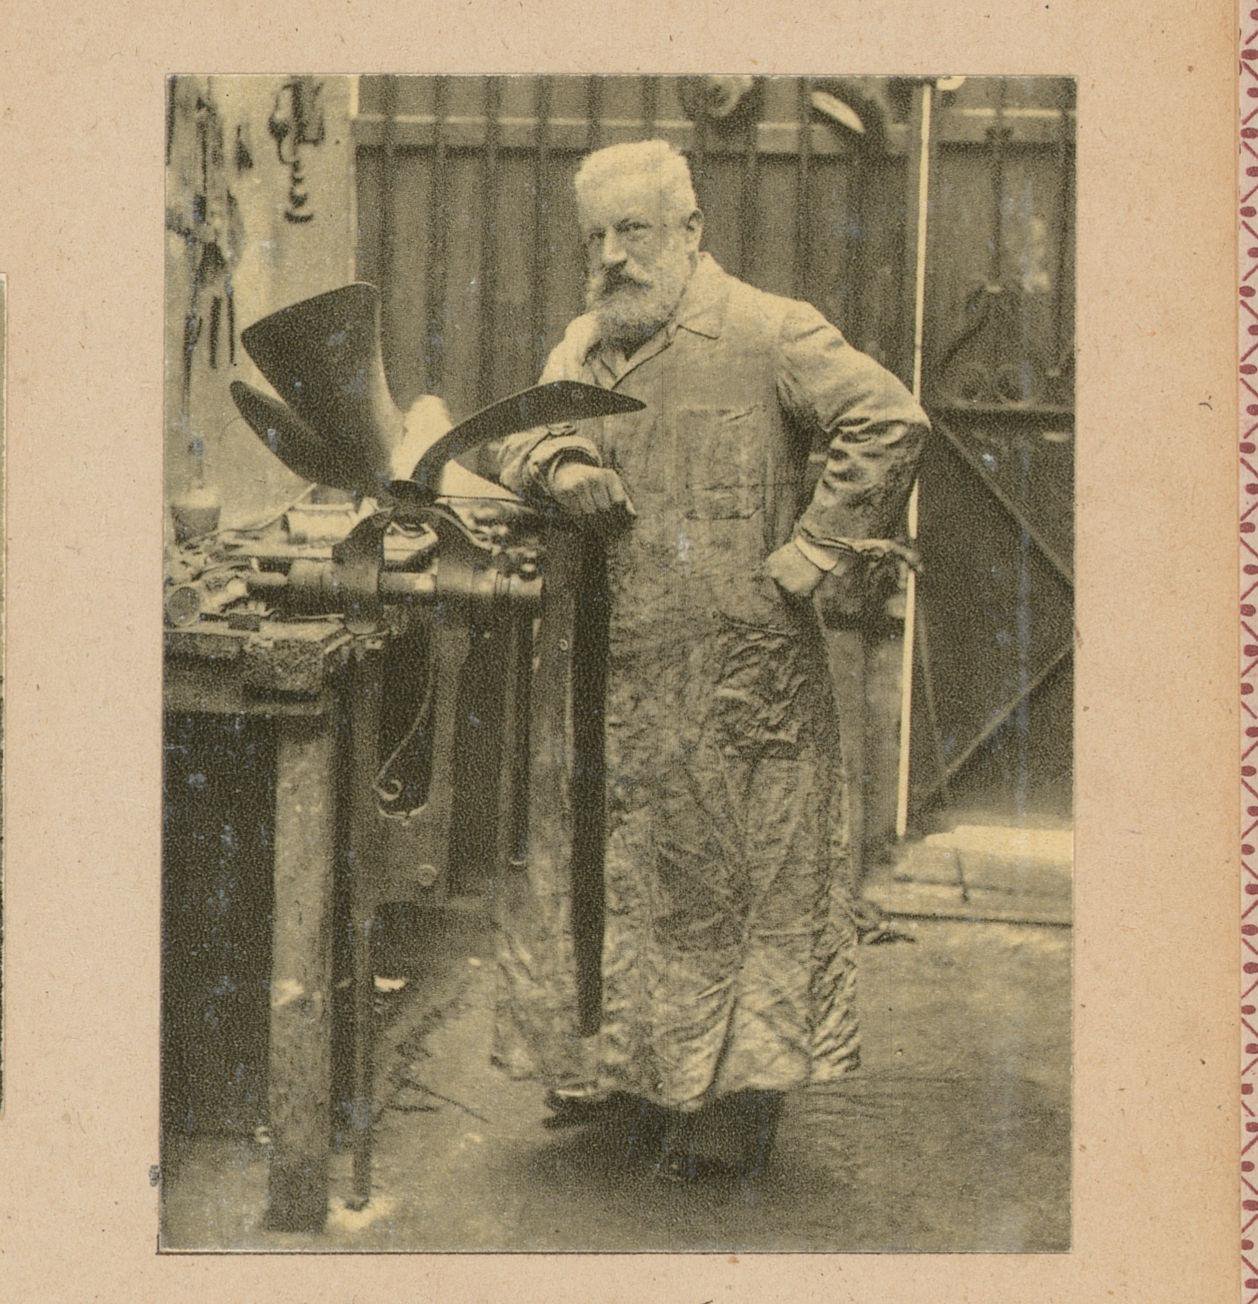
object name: album leaf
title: Portret van Fernand Forest bij een werkbank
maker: Anonymous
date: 1888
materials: paper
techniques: rotogravure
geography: france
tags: fernand forest, historical persons, science and technology (+ portrait of scholar, scientist), france